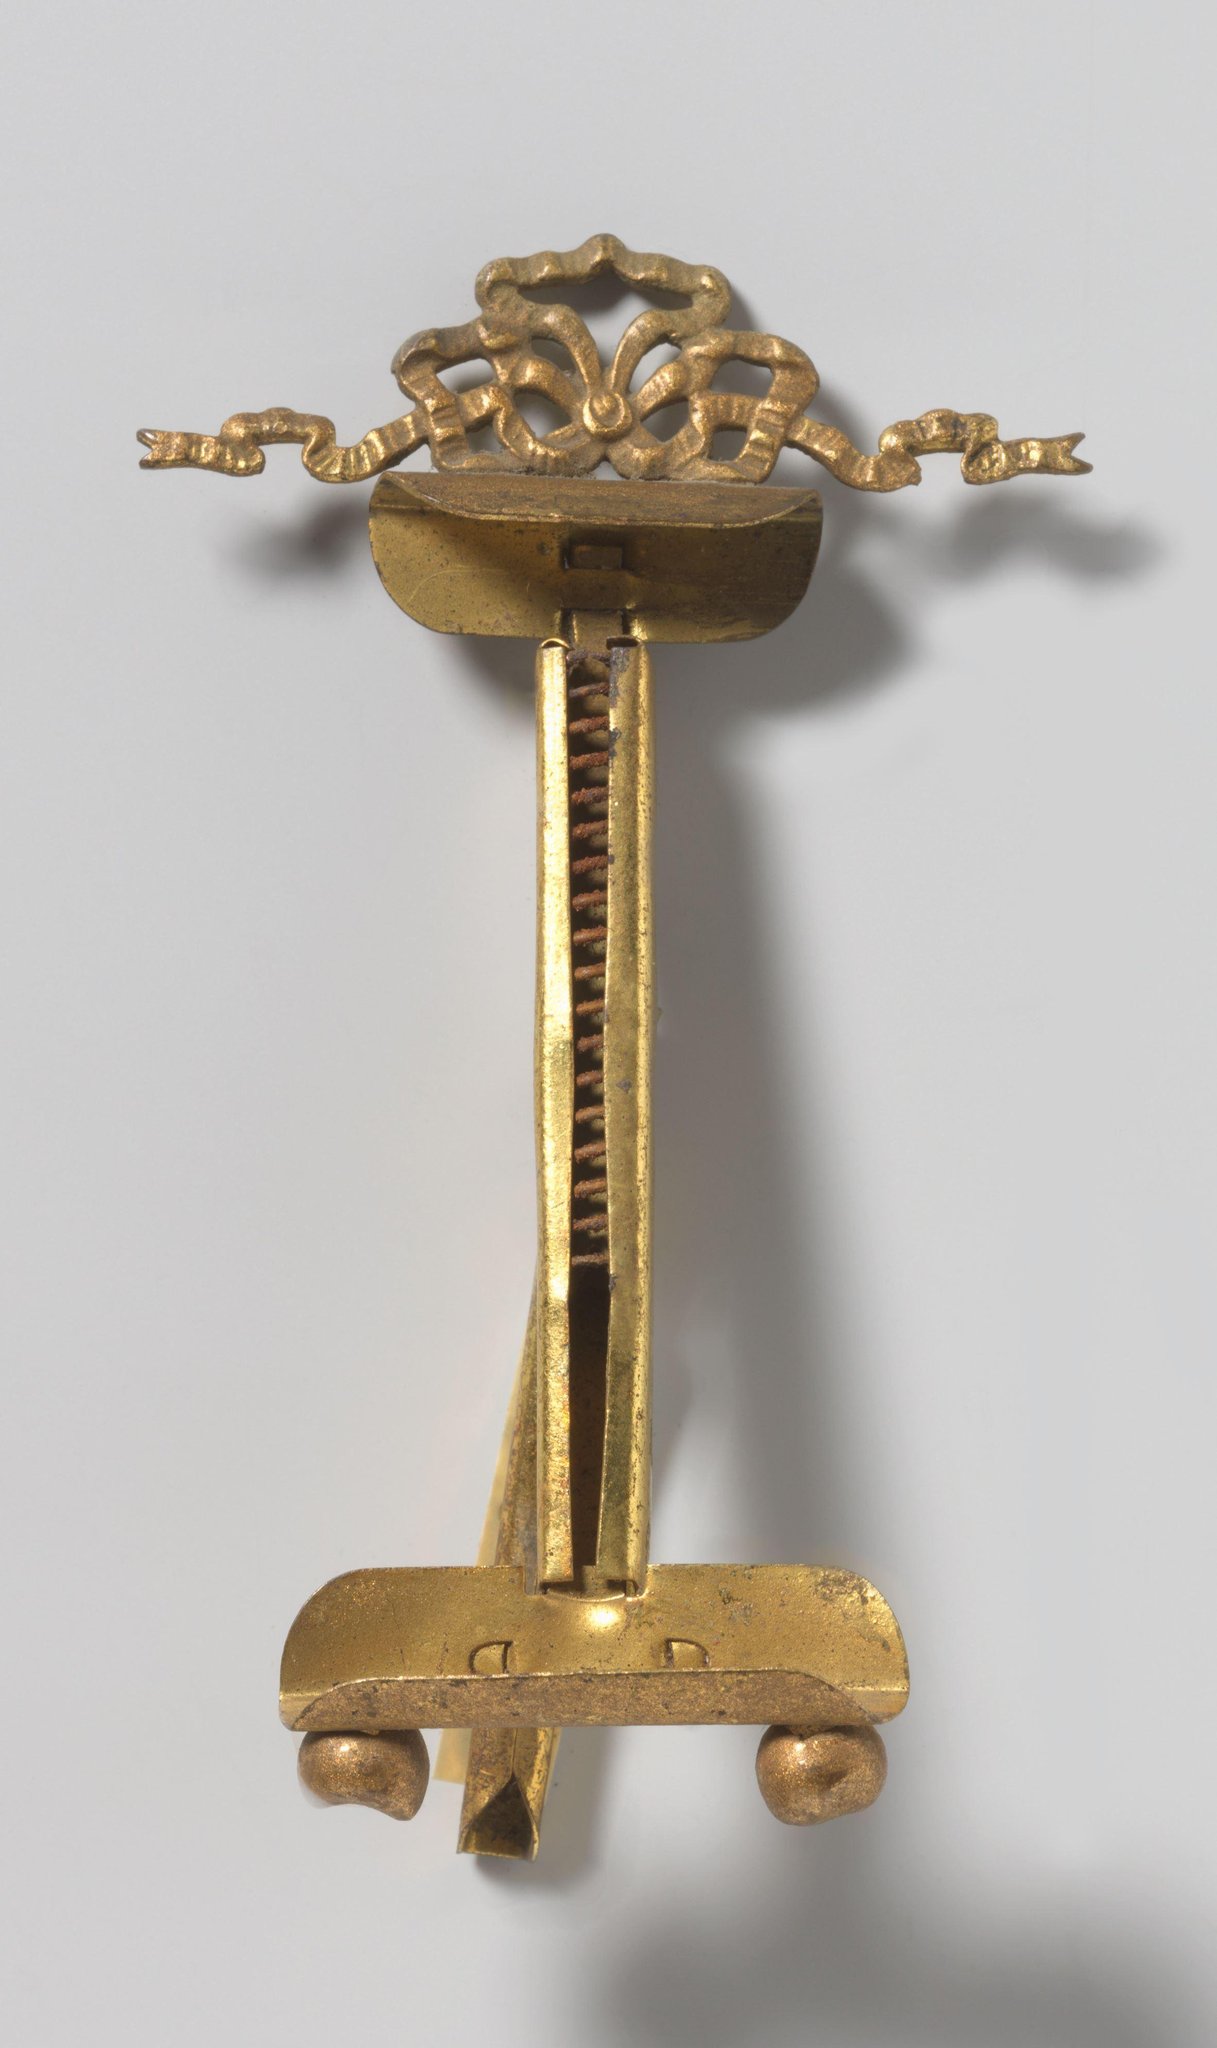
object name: frame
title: Fotostandaard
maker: Anonymous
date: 1880-1900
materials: metal